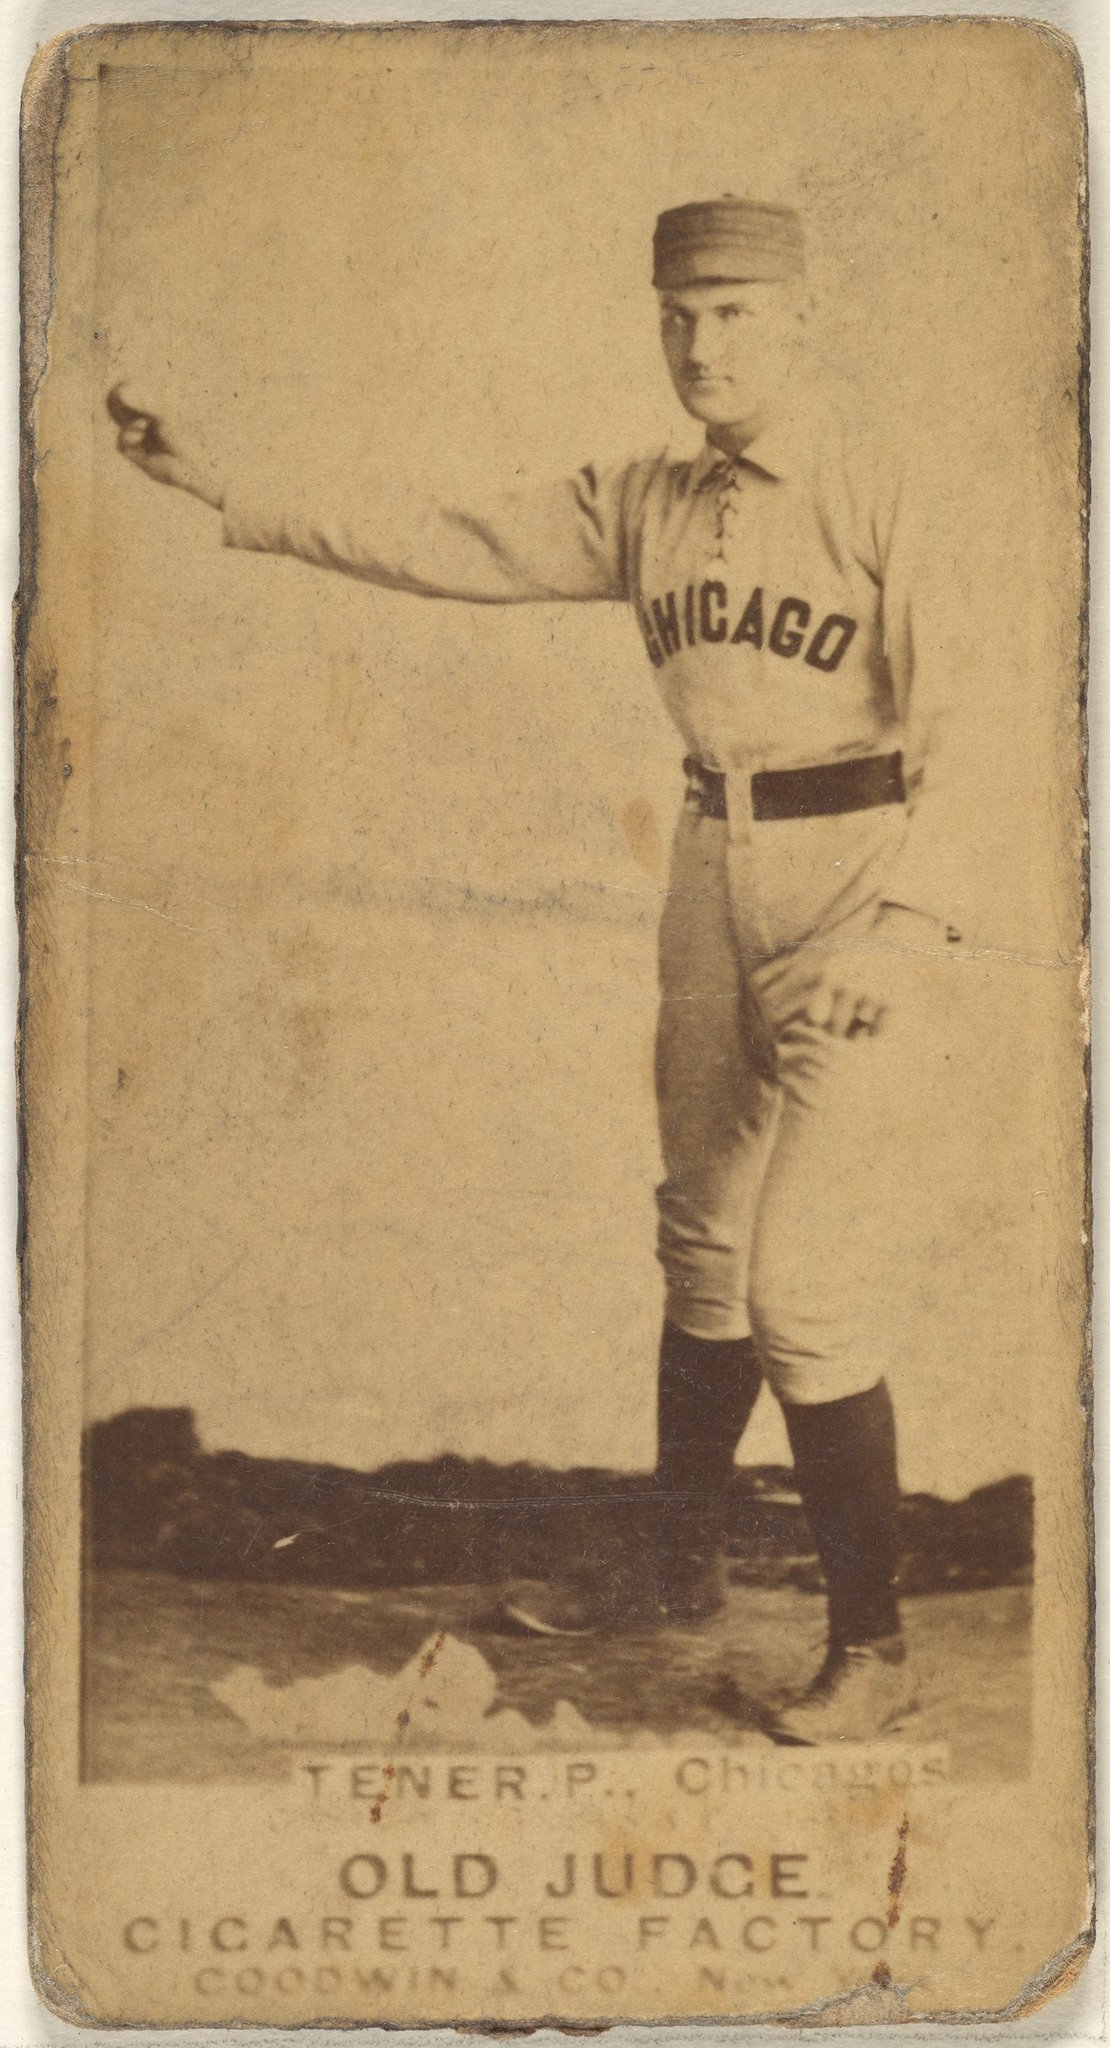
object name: baseball card, photograph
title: Tener, Pitcher, Chicago, from the Old Judge series (N172) for Old Judge Cigarettes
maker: goodwin & company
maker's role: publisher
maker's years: 1850-1950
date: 1887-1890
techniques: albumen silver print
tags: men,portraits,baseball,athletes